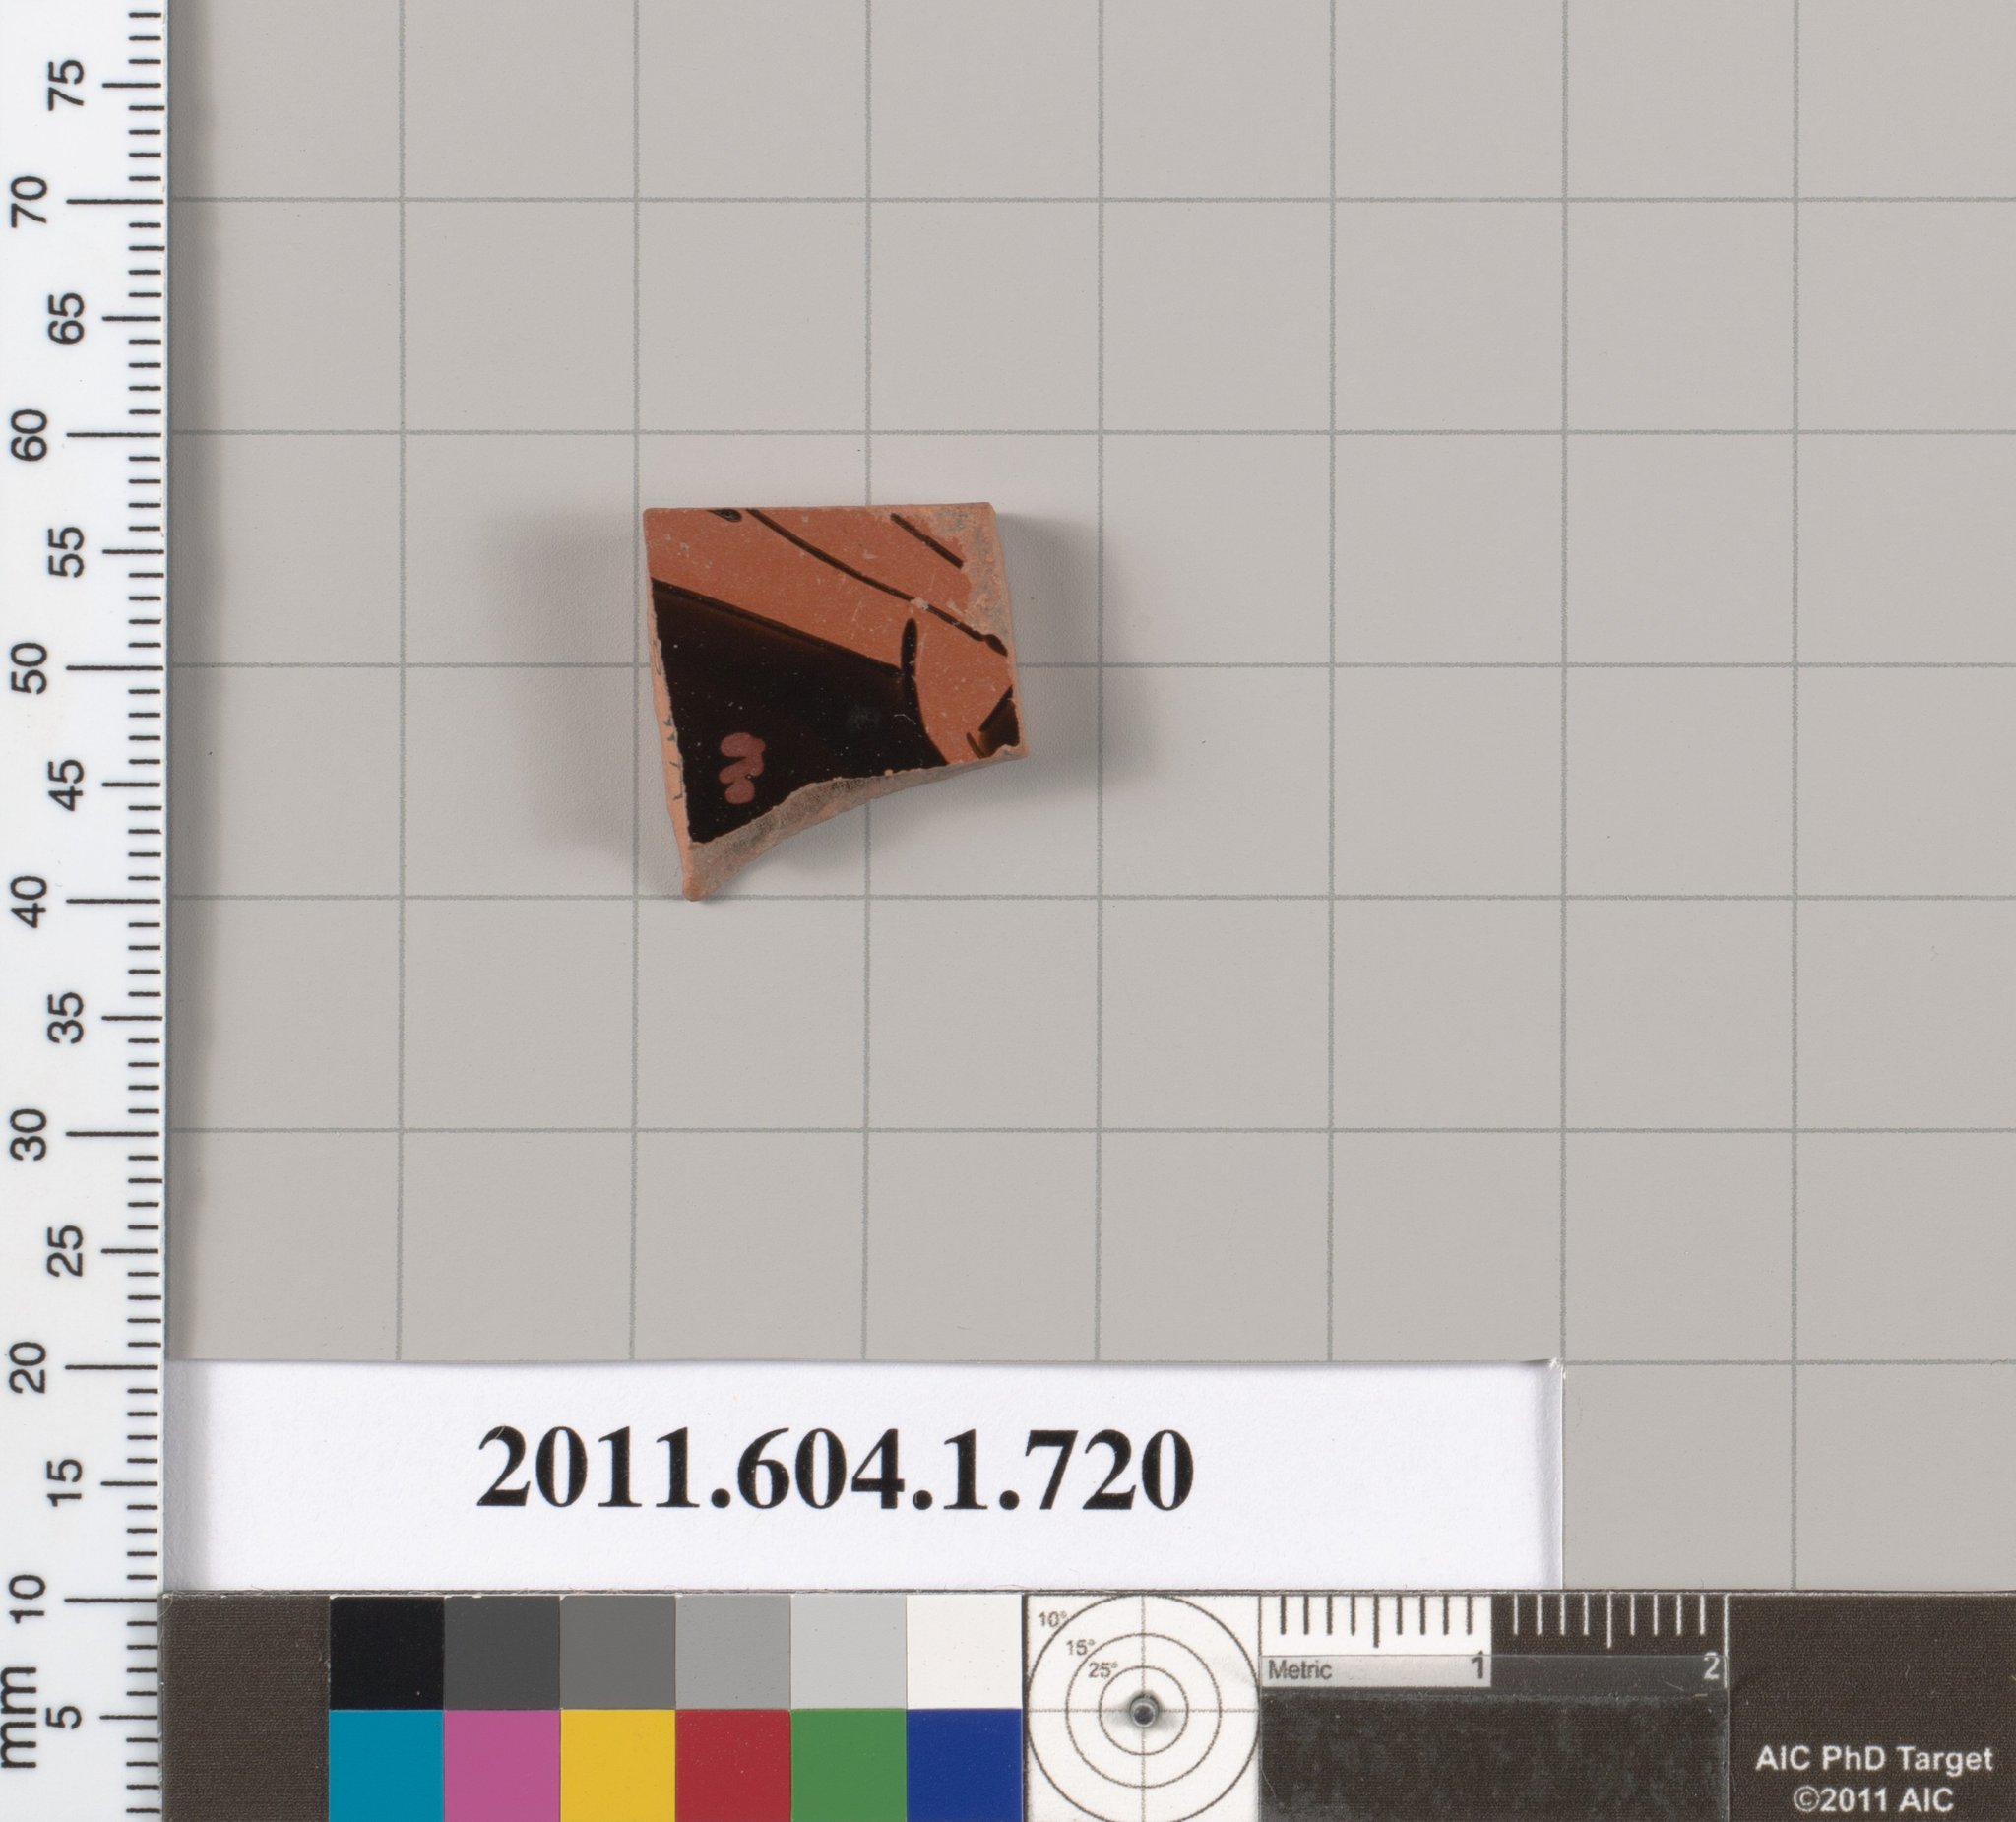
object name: kylix fragment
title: Terracotta fragment of a kylix (drinking cup)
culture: greek, attic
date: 500-476 BCE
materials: terracotta